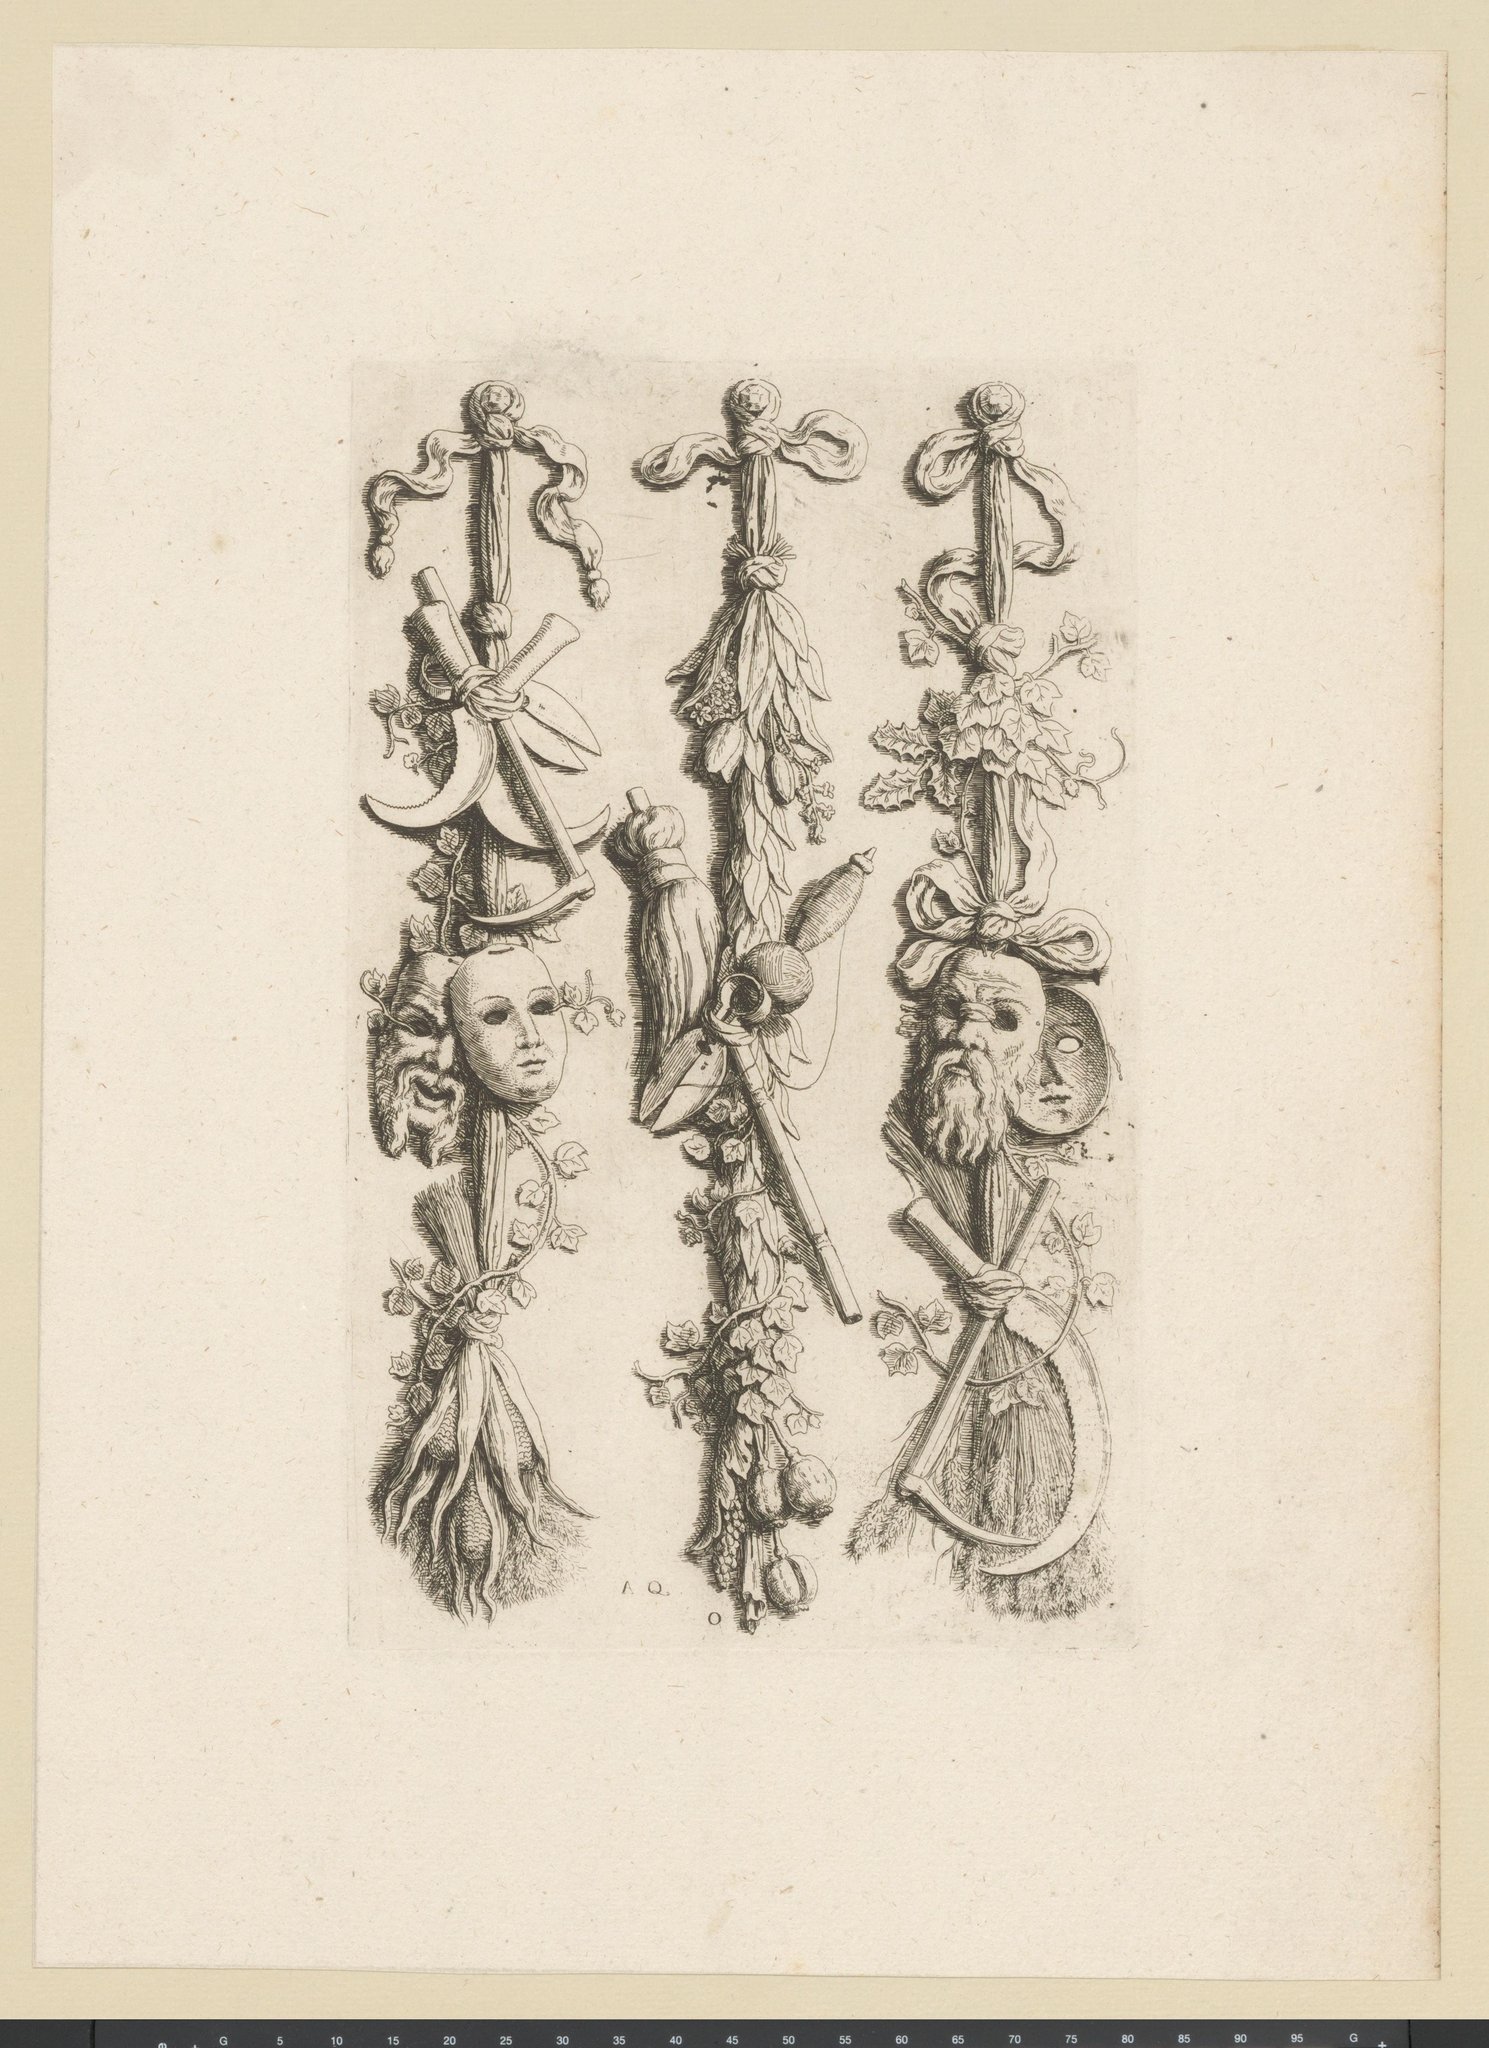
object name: print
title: Drie pilasterfestoenen in de noordelijke galerij van het Stadhuis op de Dam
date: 1655-1665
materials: paper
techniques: engraving, etching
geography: amsterdam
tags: mask, fruits and vegetables ~ ornament, spindle, townhall, ornament ~ festoon, garland, agricultural implements: sickle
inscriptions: collector's mark: ‘16,50’ Lugt 1641b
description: Prent gebruikt in: Prima pars. Praecipuarum effigierum ac ornamentorum, amplissimae Curiae Amstelrodamensis (…) / Het eerste deel. Van de voornaemste Statuen ende Ciraten, vant konstijck Stadhuys van Amstelredam, tmeeste in marmer gemaeckt, door Artus Quellinus, Beelthouwer der voorseyde Stadt / La Premier Partie. De plusieurs Figures et ornements, de la Maison de Ville d'Amsterdam (…). Amsterdam: Artus Quellinus (I), 1655. Zie RP-P-AO-22-1-1 voor bijhorende titelpagina. Zie RP-P-AO-22-1-2 voor bijhorend register. Zie RP-P-AO-22-1A, RP-P-AO-22-1B, RP-P-AO-22-1C, RP-P-AO-22-1D-1, RP-P-AO-22-1D-2, RP-P-AO-22-1E, RP-P-AO-22-1F, RP-P-AO-22-1G, RP-P-AO-22-1H, RP-P-AO-22-1I, RP-P-AO-22-1K-1, RP-P-AO-22-1K-2, RP-P-AO-22-1K-3, RP-P-AO-22-1K-4, RP-P-AO-22-1K-5, RP-P-AO-22-1L-1, RP-P-AO-22-1L-2, RP-P-AO-22-1M-1, RP-P-AO-22-1M-2, RP-P-AO-22-1N-1, RP-P-AO-22-1N-2, RP-P-AO-22-1N-3, RP-P-AO-22-1N-4, RP-P-AO-22-1N-5, RP-P-AO-22-1O-1, RP-P-AO-22-1O-3, RP-P-AO-22-1O-4, RP-P-AO-22-1P-1, RP-P-AO-22-1P-2, RP-P-AO-22-1P-3, RP-P-AO-22-1P-4, RP-P-AO-22-1Q-1, RP-P-AO-22-1Q-2, RP-P-AO-22-1Q-3, RP-P-AO-22-1Q-4, RP-P-AO-22-1R-1, RP-P-AO-22-1R-2, RP-P-AO-22-1R-3, RP-P-AO-22-1R-4, RP-P-AO-22-1R-5, RP-P-AO-22-1S-1, RP-P-AO-22-1S-2, RP-P-AO-22-1S-3, RP-P-AO-22-1S-4, RP-P-AO-22-1S-5, RP-P-AO-22-1T-1 en RP-P-AO-22-1T-2 voor andere prenten uit deze publicatie. Zelfde staat van prent ook gebruikt in: Prima pars. Praecipuarum effigierum ac ornamentorum, amplissimae Curiae Amstelrodamensis (…) / Het eerste deel. Van de voornaemste Statuen ende Ciraten, vant konstijck Stadhuys van Amstelredam, tmeeste in marmer gemaeckt, door Artus Quellinus, Beelthouwer der voorseyde Stadt / La Premier Partie. De plusieurs Figures et ornements, de la Maison de Ville d'Amsterdam (…). Amsterdam: Frederik de Wit, 1665. Latere staat van prent ook gebruikt in: Architecture peinture et sculpture de la Maison de Ville d'Amsterdam, representee en CIX. figures en taille-douce (…). Amsterdam: David Mortier, 1719. En in: Architecture peinture et sculpture de la Maison de Ville d'Amsterdam, representee en CIX. figures en taille-douce (…). Amsterdam: Gerard Valck, 1719. En in: Bouw schilder en beeldhouwkonst, van het Stadhuis te Amsteldam, vertoont in CIX figuuren (…). Amsterdam: Covens & Mortier & Covens Jr., s.a. (1774-1783).